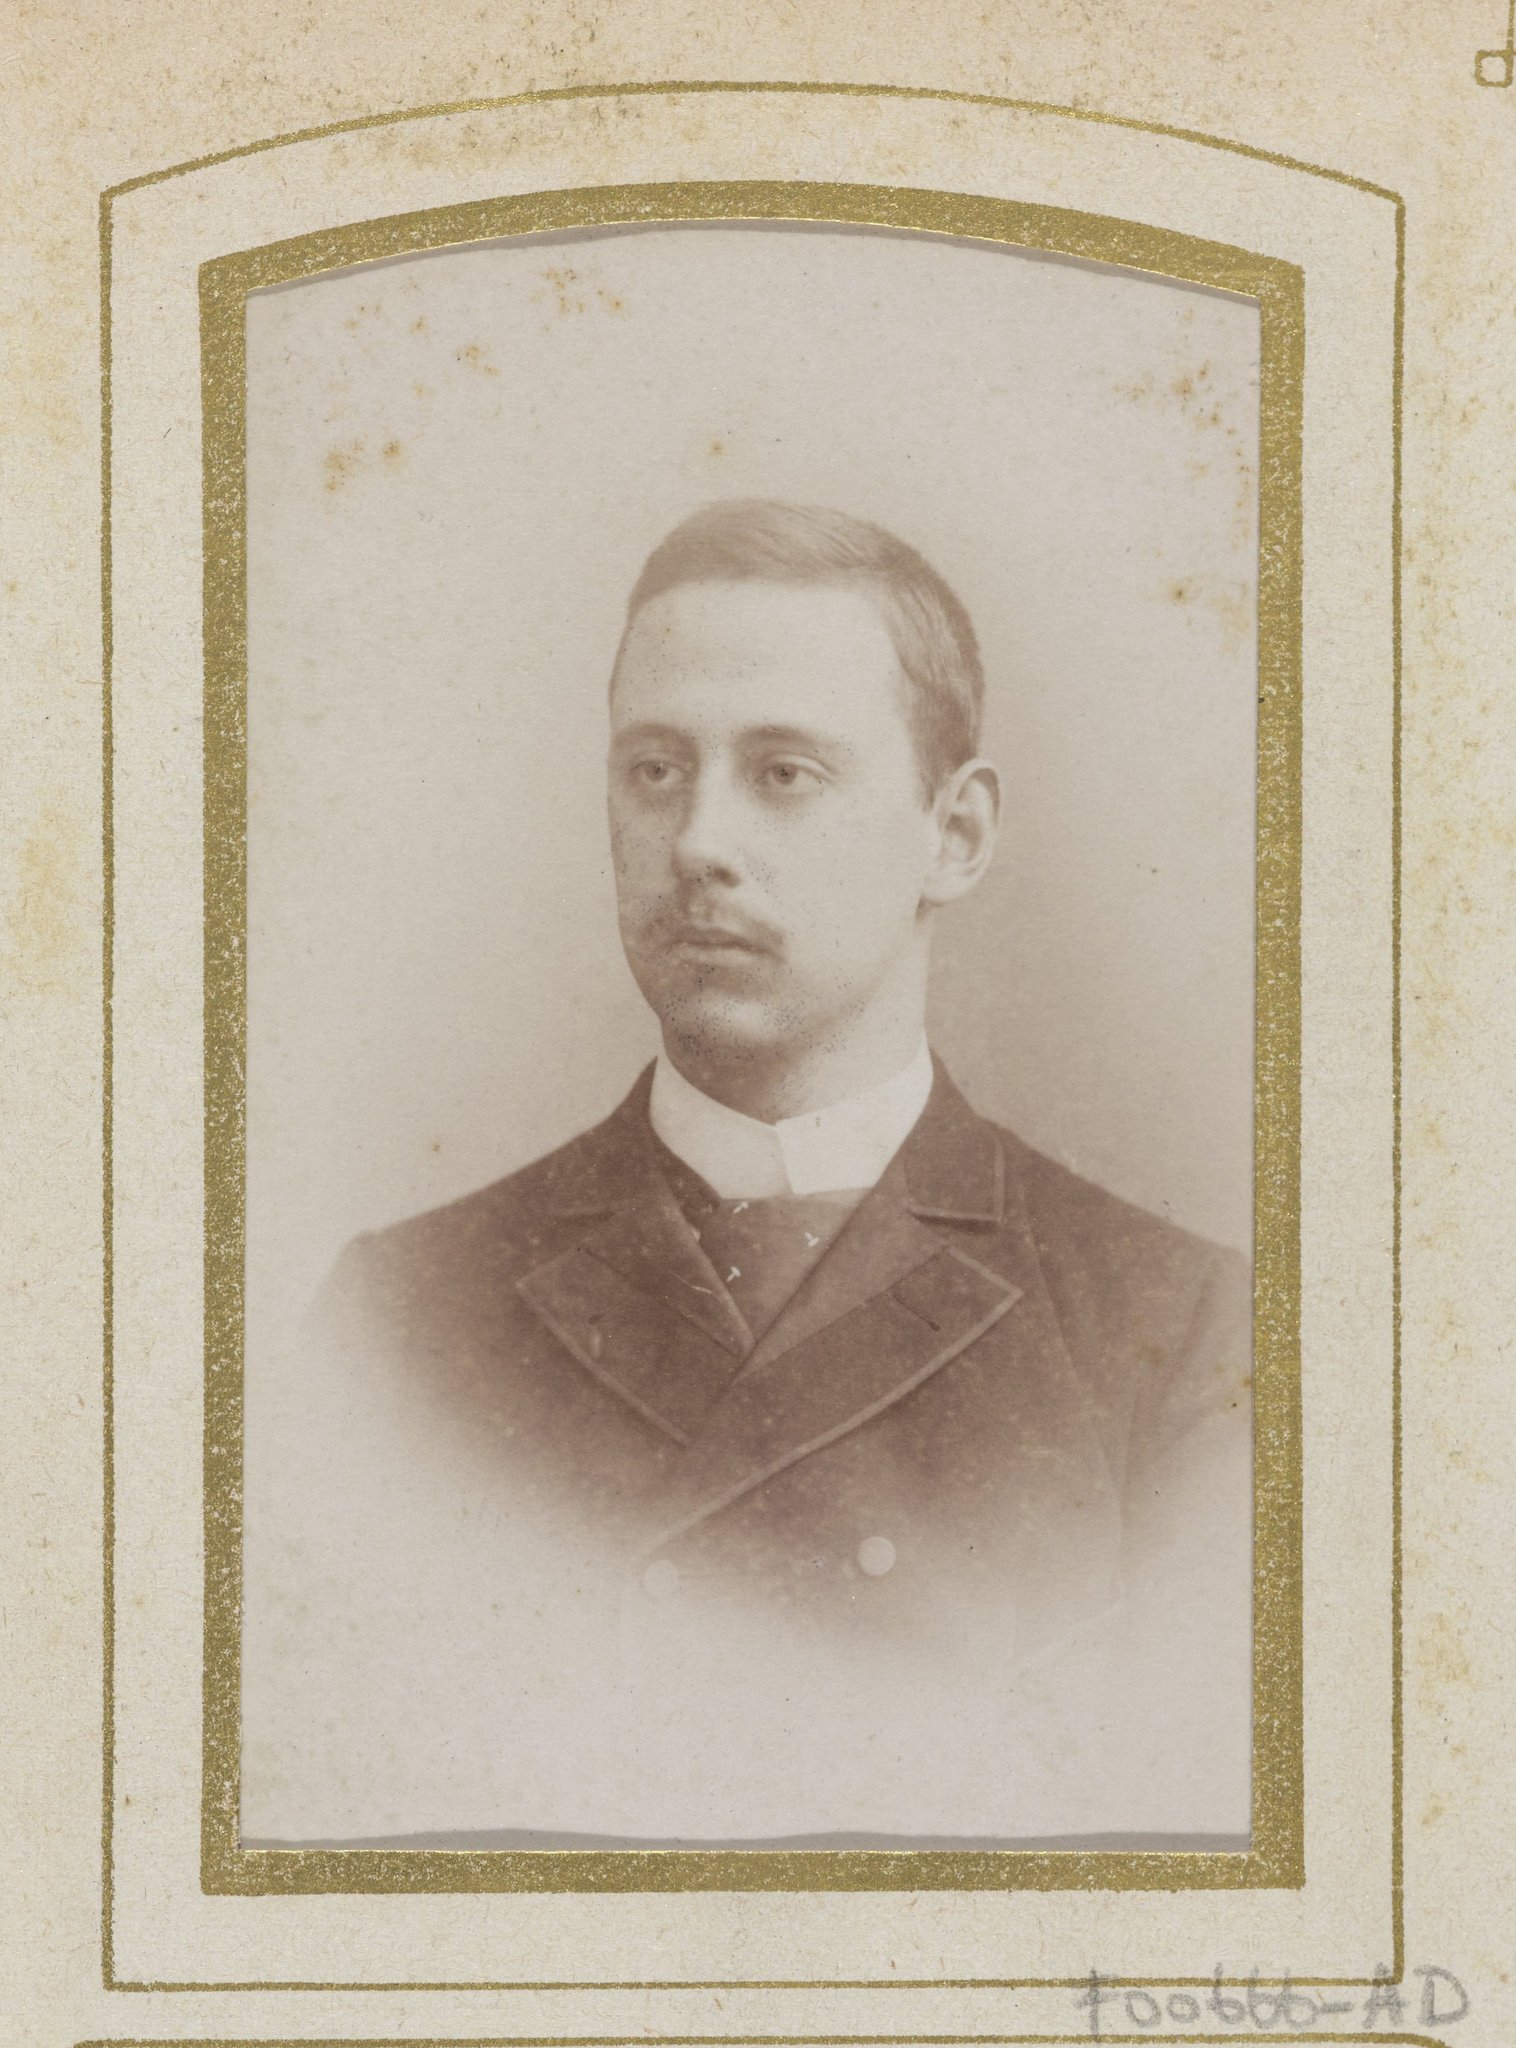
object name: album leaf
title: Portret van een jonge man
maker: lodewijk van de winkel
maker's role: fotograaf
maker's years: 1856-1919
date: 1881-1900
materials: cardboard, photographic support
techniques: albumen print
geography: rotterdam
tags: historical persons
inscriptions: inscription: ‘ATELIER SPÉCIAL/ DE REPRODUCTIONS,/ D'AGRANDISSEMENTS/ ET PEINTURE A L'HUILE./ L. van de Winkel/ Photographie Parisienne/ Rotterdam/ 123. Rue Van Oldenbarnevelt 123.’